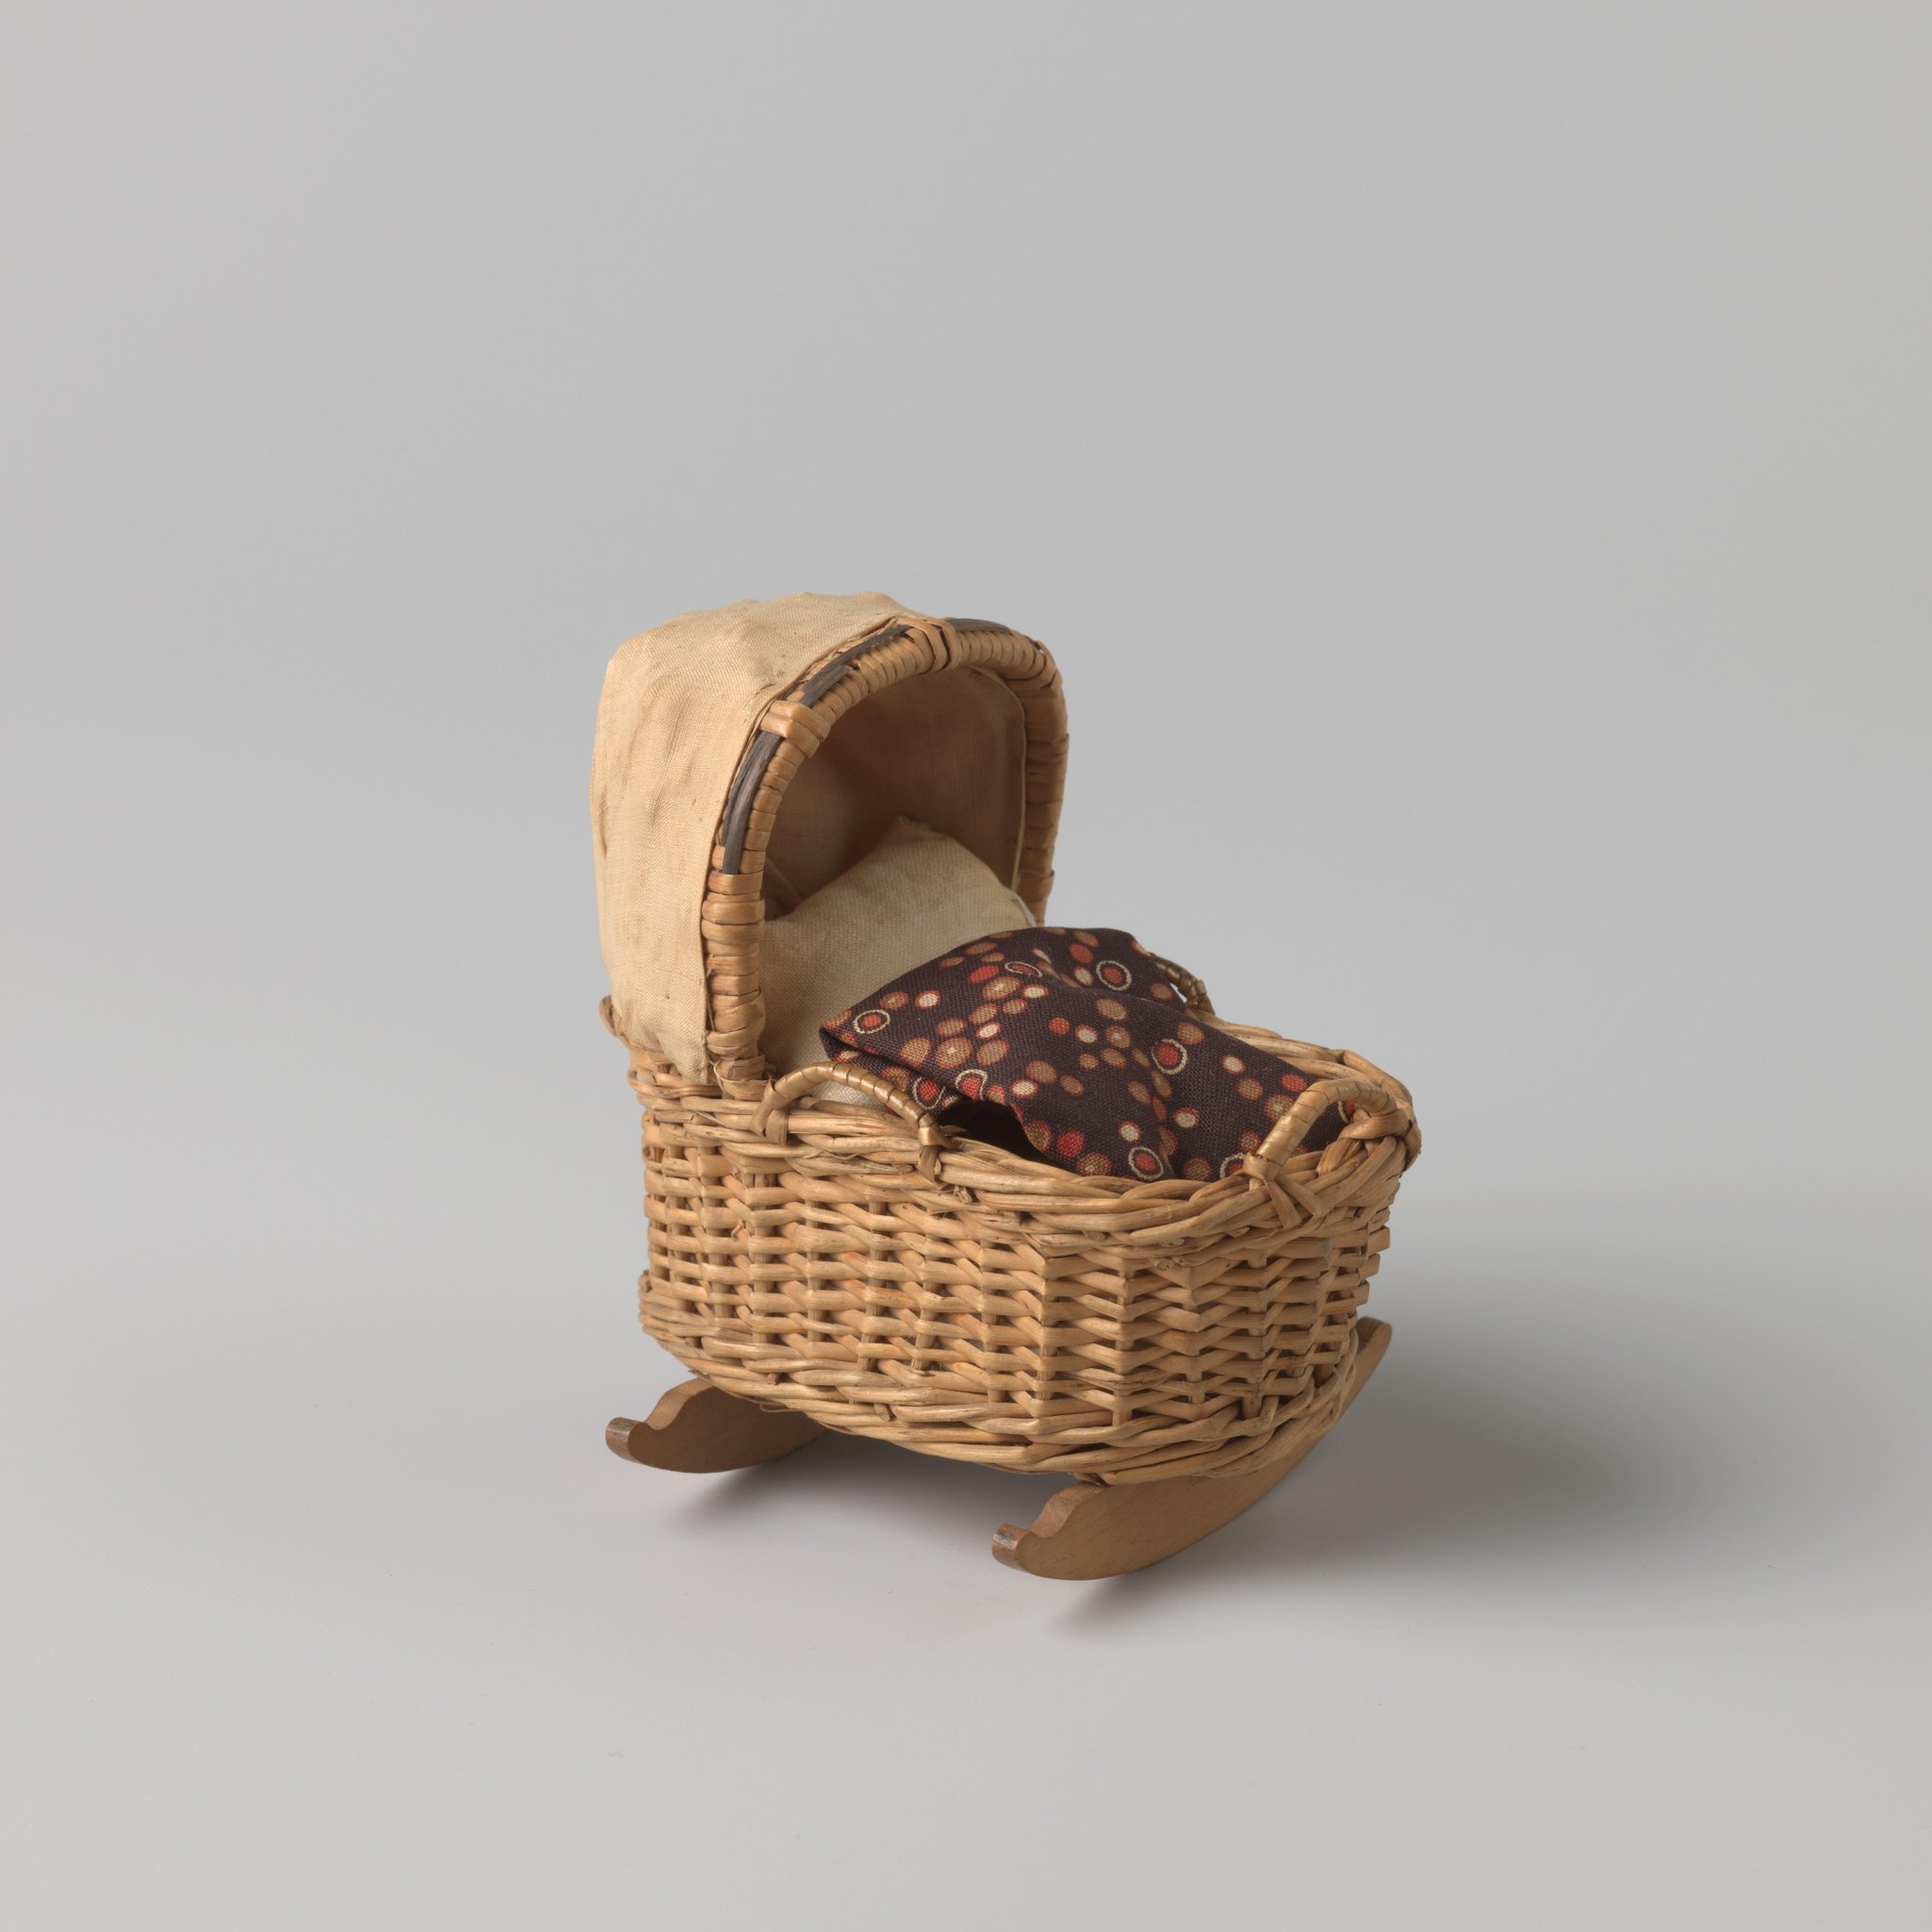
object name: cushion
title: Kussen van witte katoen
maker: Anonymous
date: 1750-1800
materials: cotton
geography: amsterdam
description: kussen uit de wieg, vervaardigd van witte katoen, gevuld met pluis.